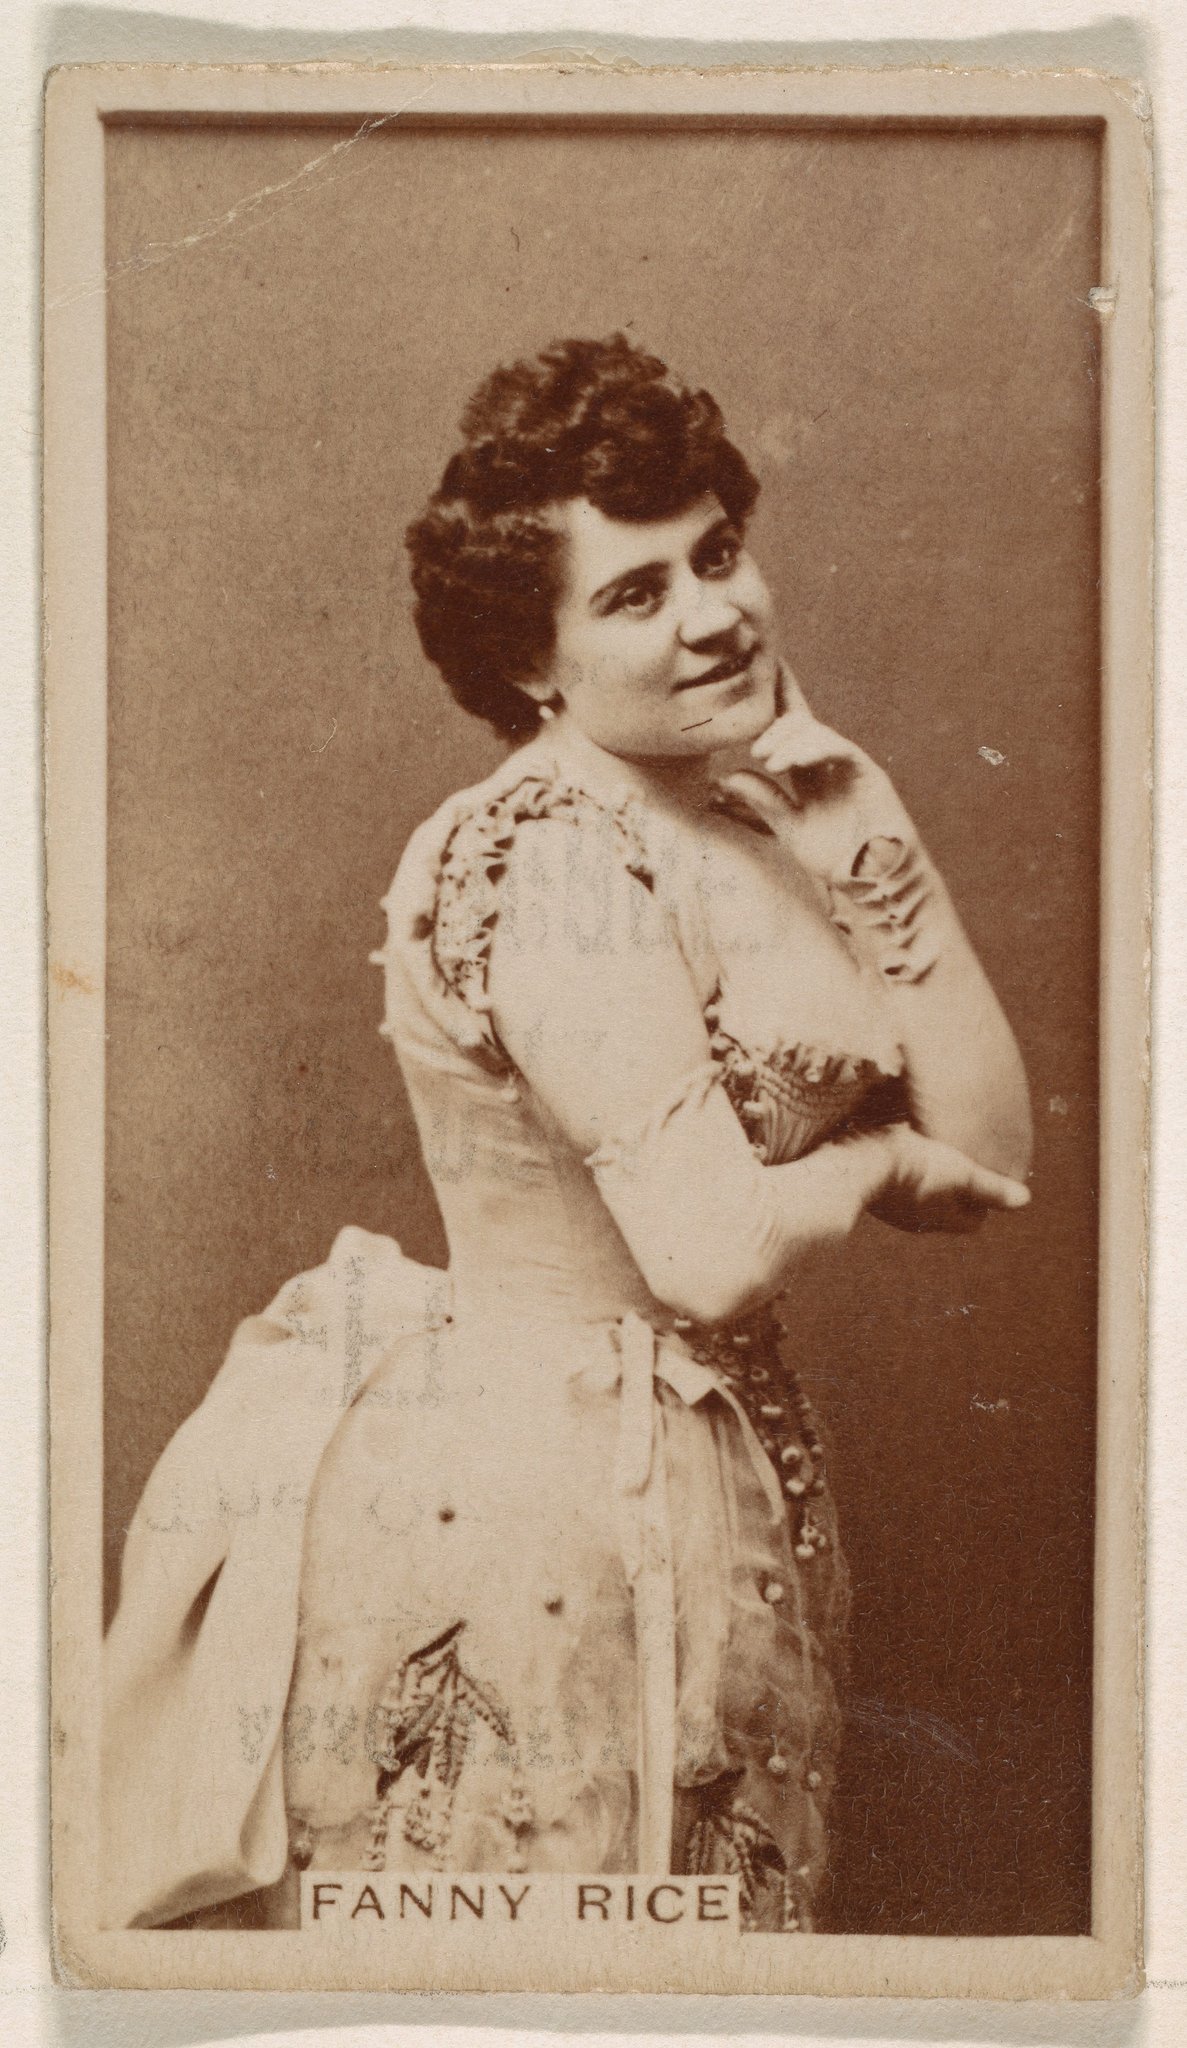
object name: photograph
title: Fanny Rice, from the Actresses series (N245) issued by Kinney Brothers to promote Sweet Caporal Cigarettes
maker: kinney brothers tobacco company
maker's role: publisher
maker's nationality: american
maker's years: 1869-2011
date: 1890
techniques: albumen silver print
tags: portraits,women,actresses